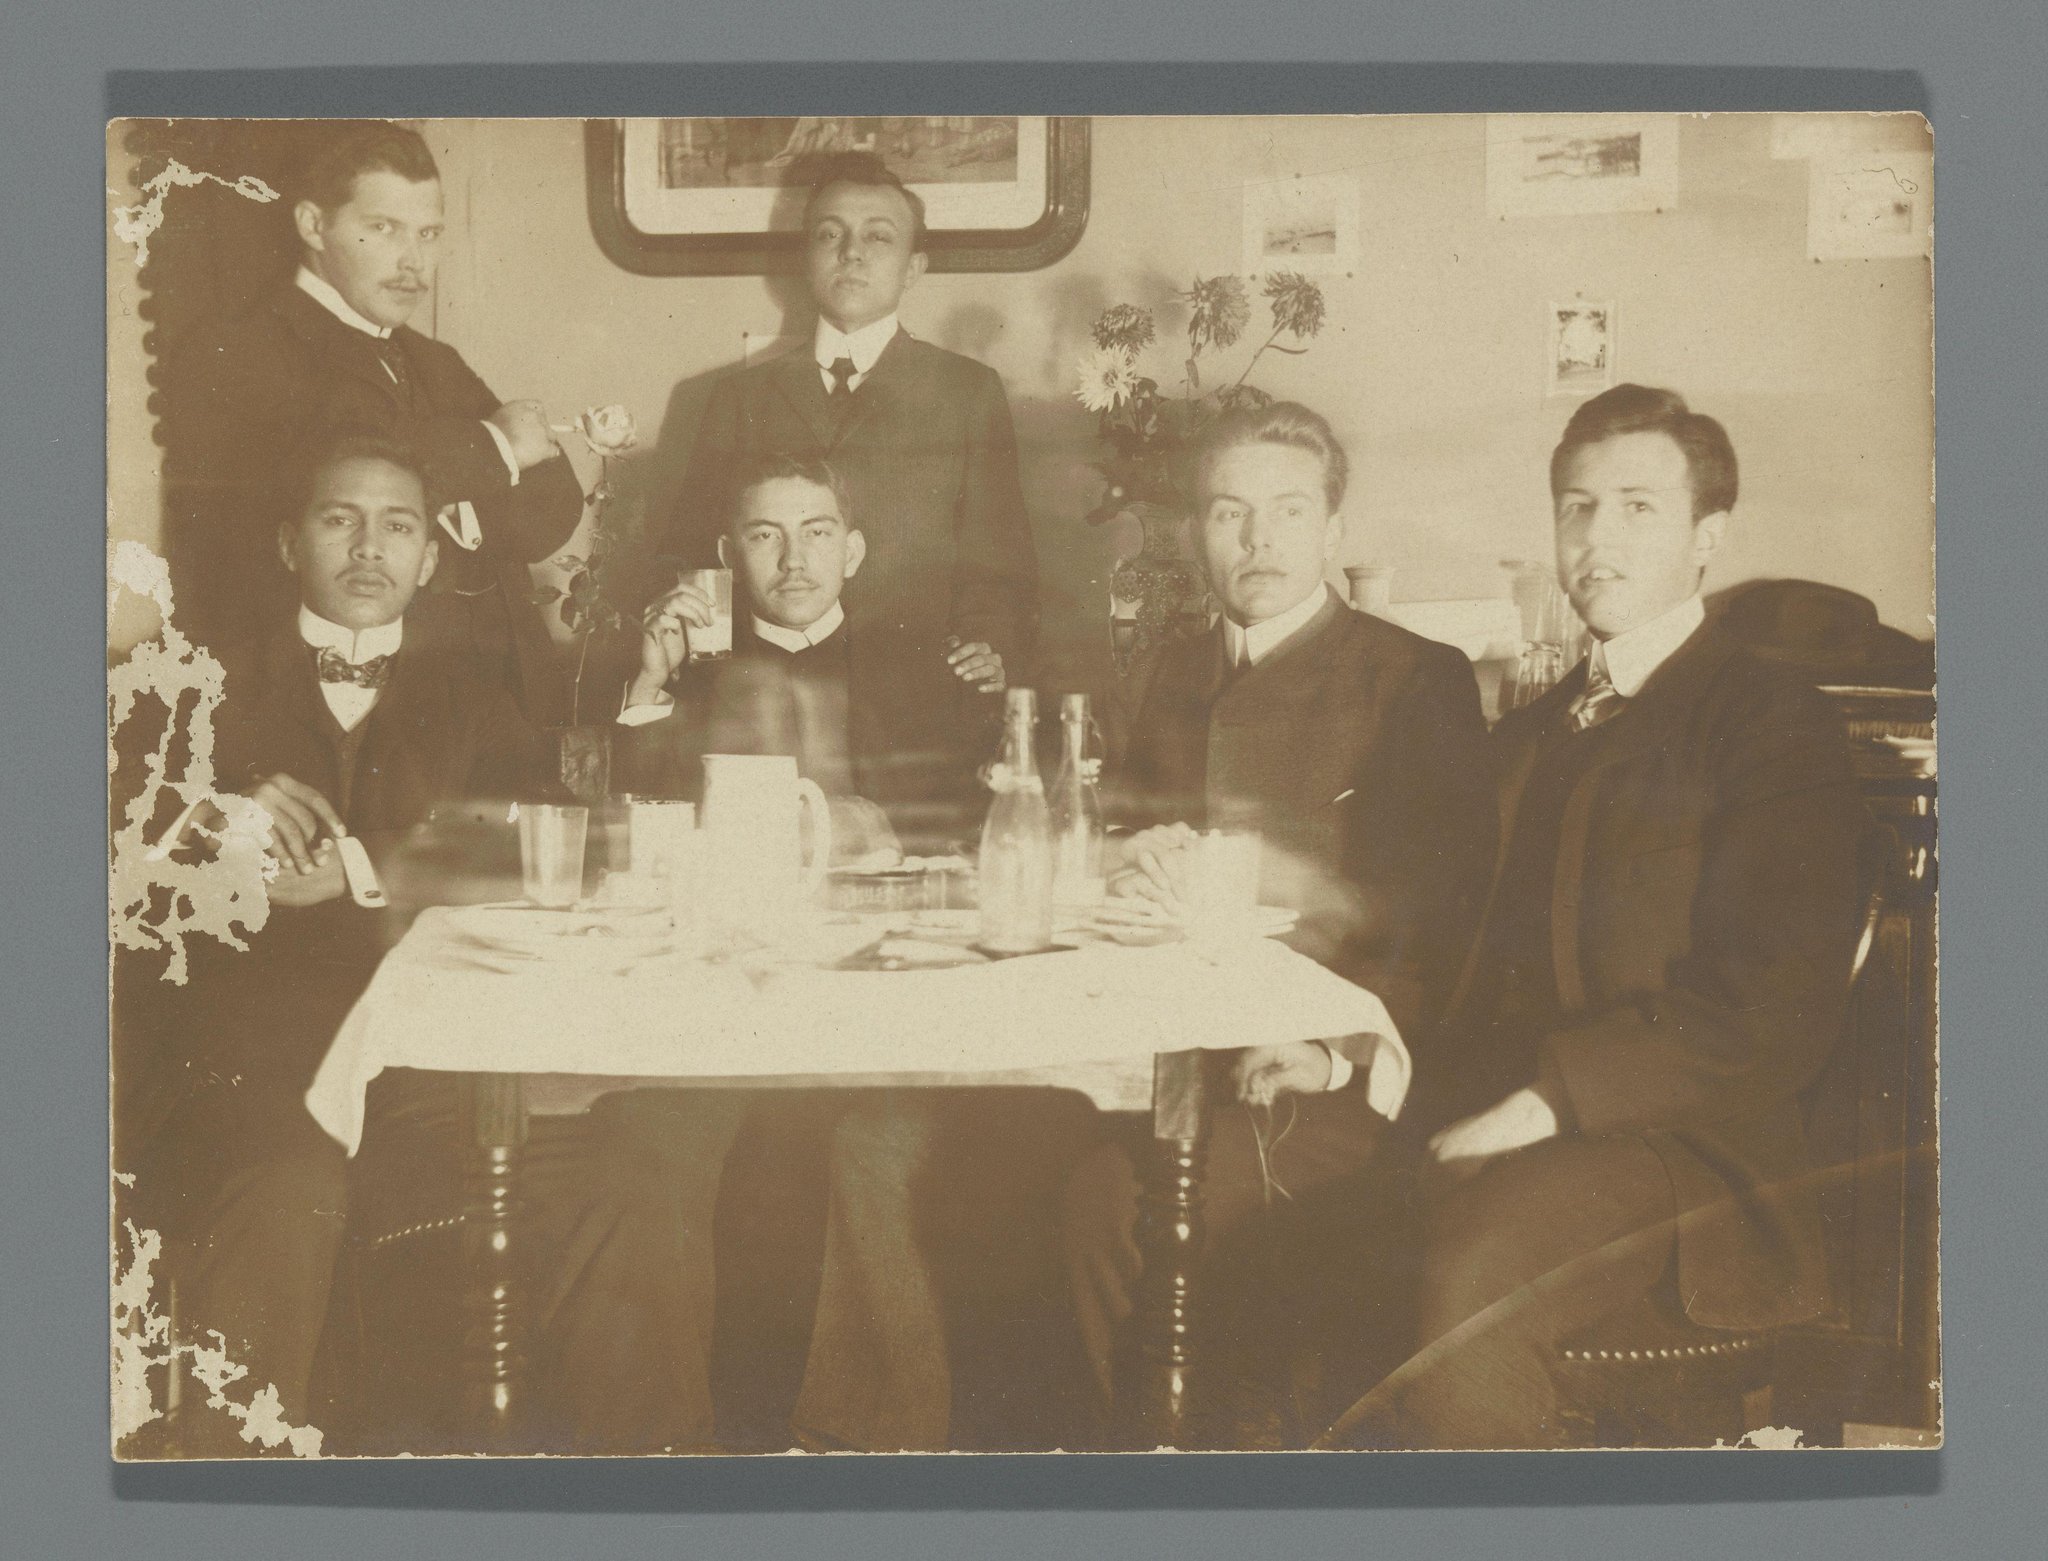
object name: photograph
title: Portret van Frédéric Dumas en zijn Delftse medestudenten, rokend rond een tafel met lege glazen, flessen en kan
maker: Anonymous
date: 1906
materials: photographic support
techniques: gelatin silver print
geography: delft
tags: engineer, frédéric gabriël dumas, university, historical persons, student life, delft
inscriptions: annotation: ‘voor mijn lieveling’